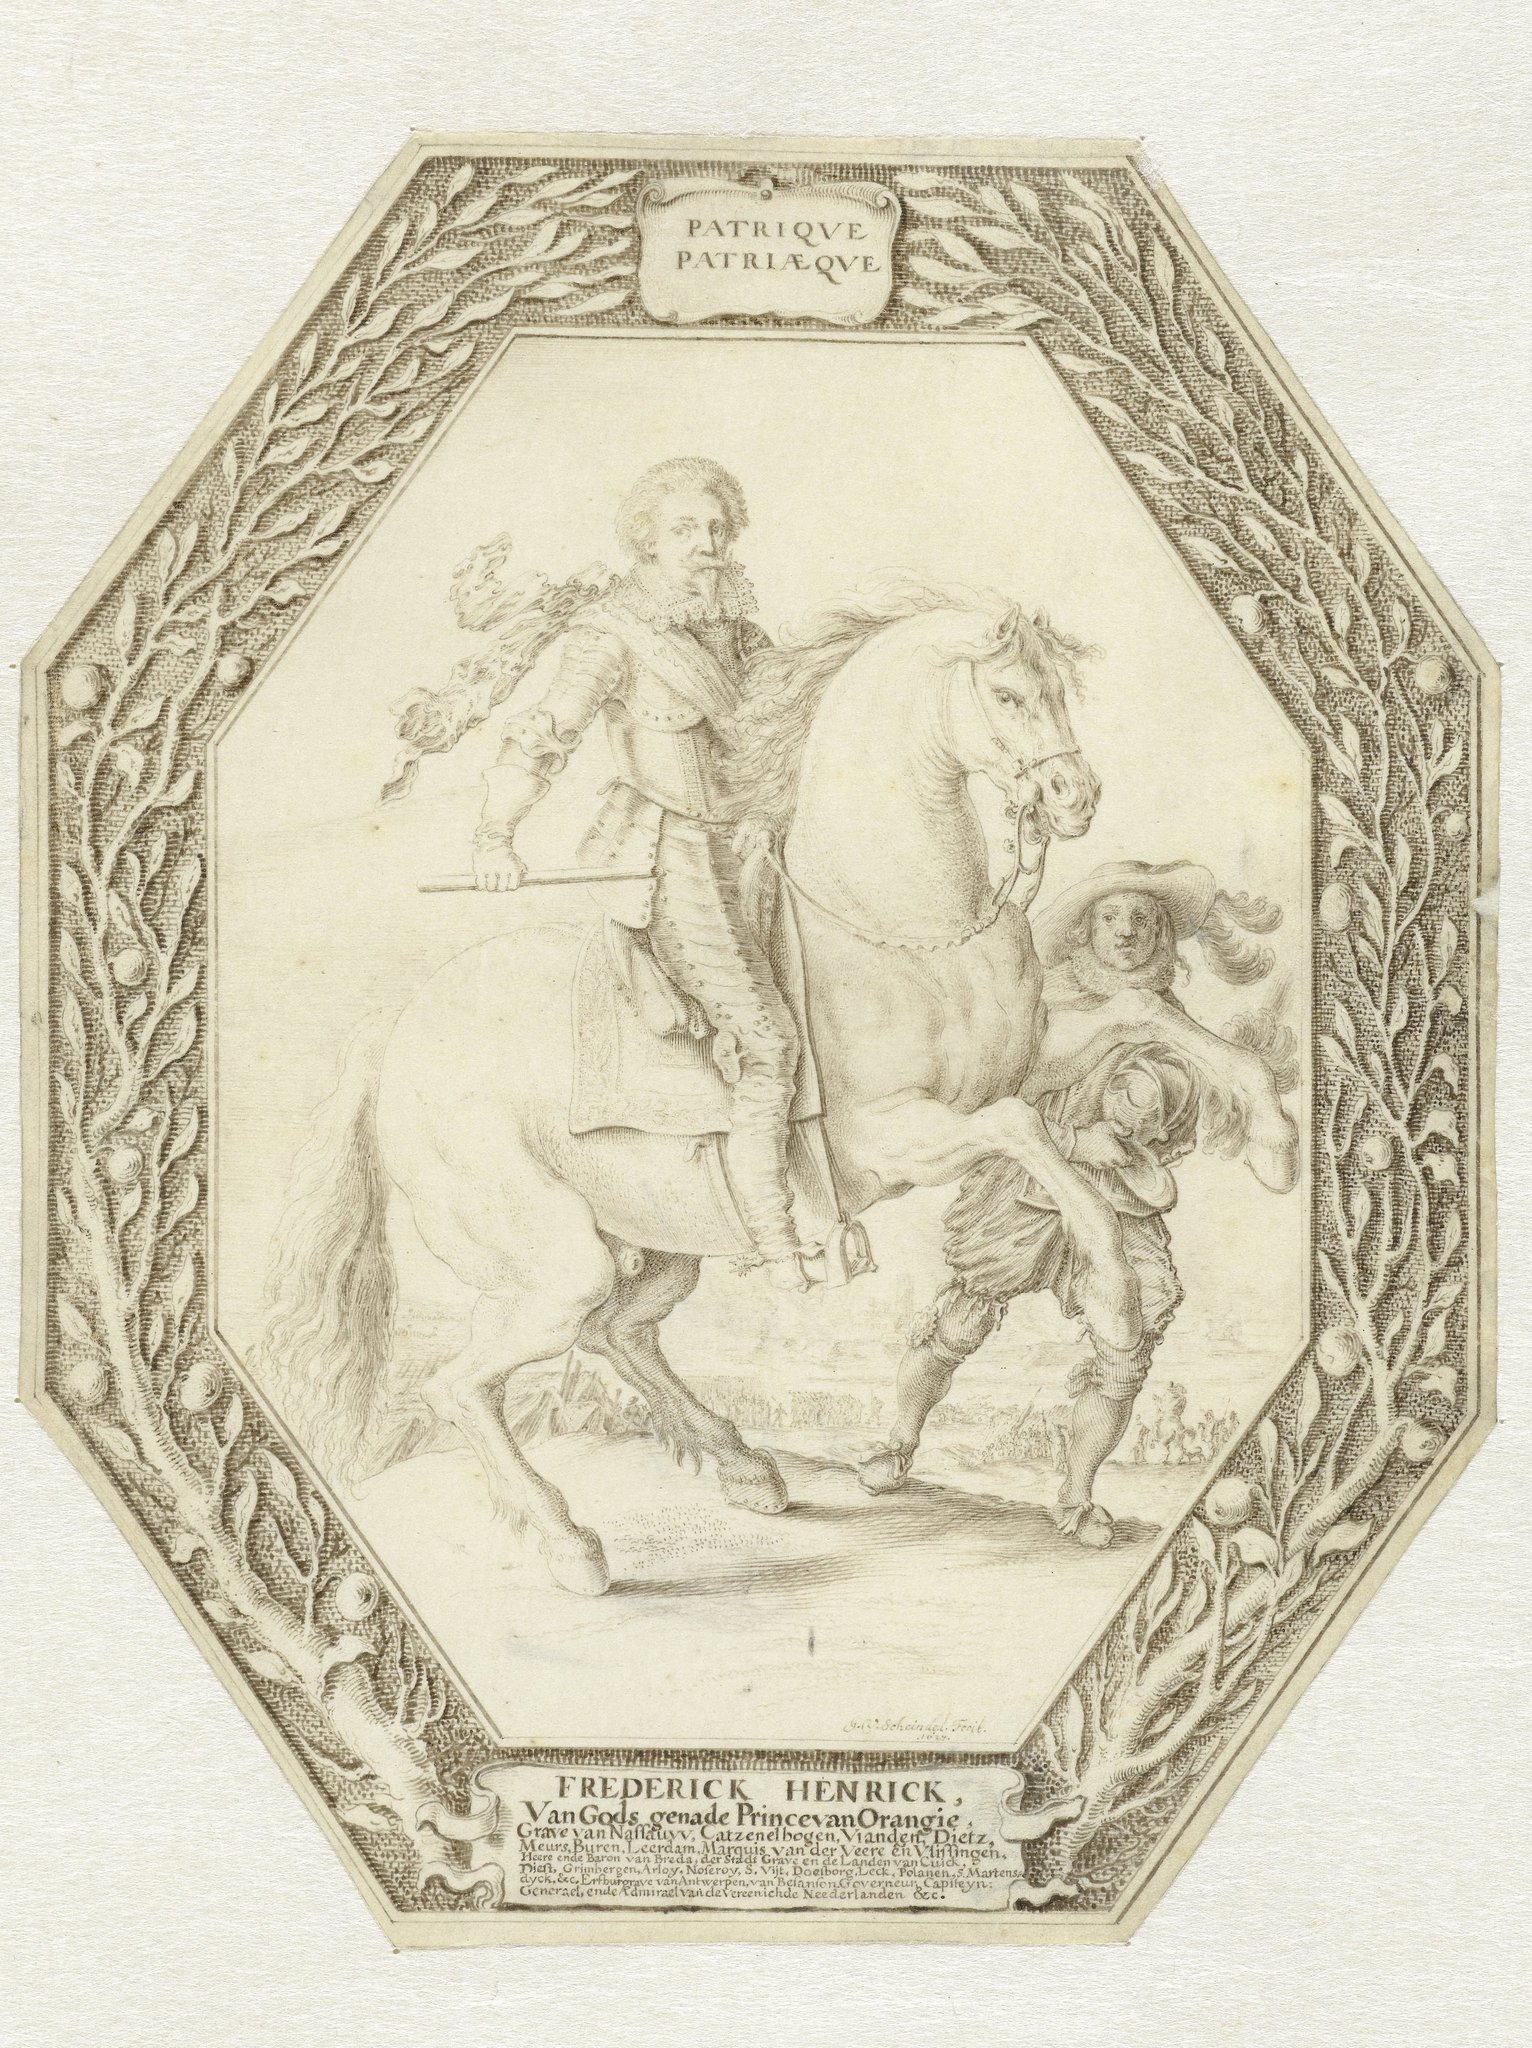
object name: drawing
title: Portret van Prins Frederik Hendrik, te paard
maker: gillis van scheyndel (i)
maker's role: draughtsman, print maker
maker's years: 1595-1660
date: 1627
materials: ink, parchment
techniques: pen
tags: delft, the hague, frederick henry (prince of orange), equestrian state-portrait, historical persons